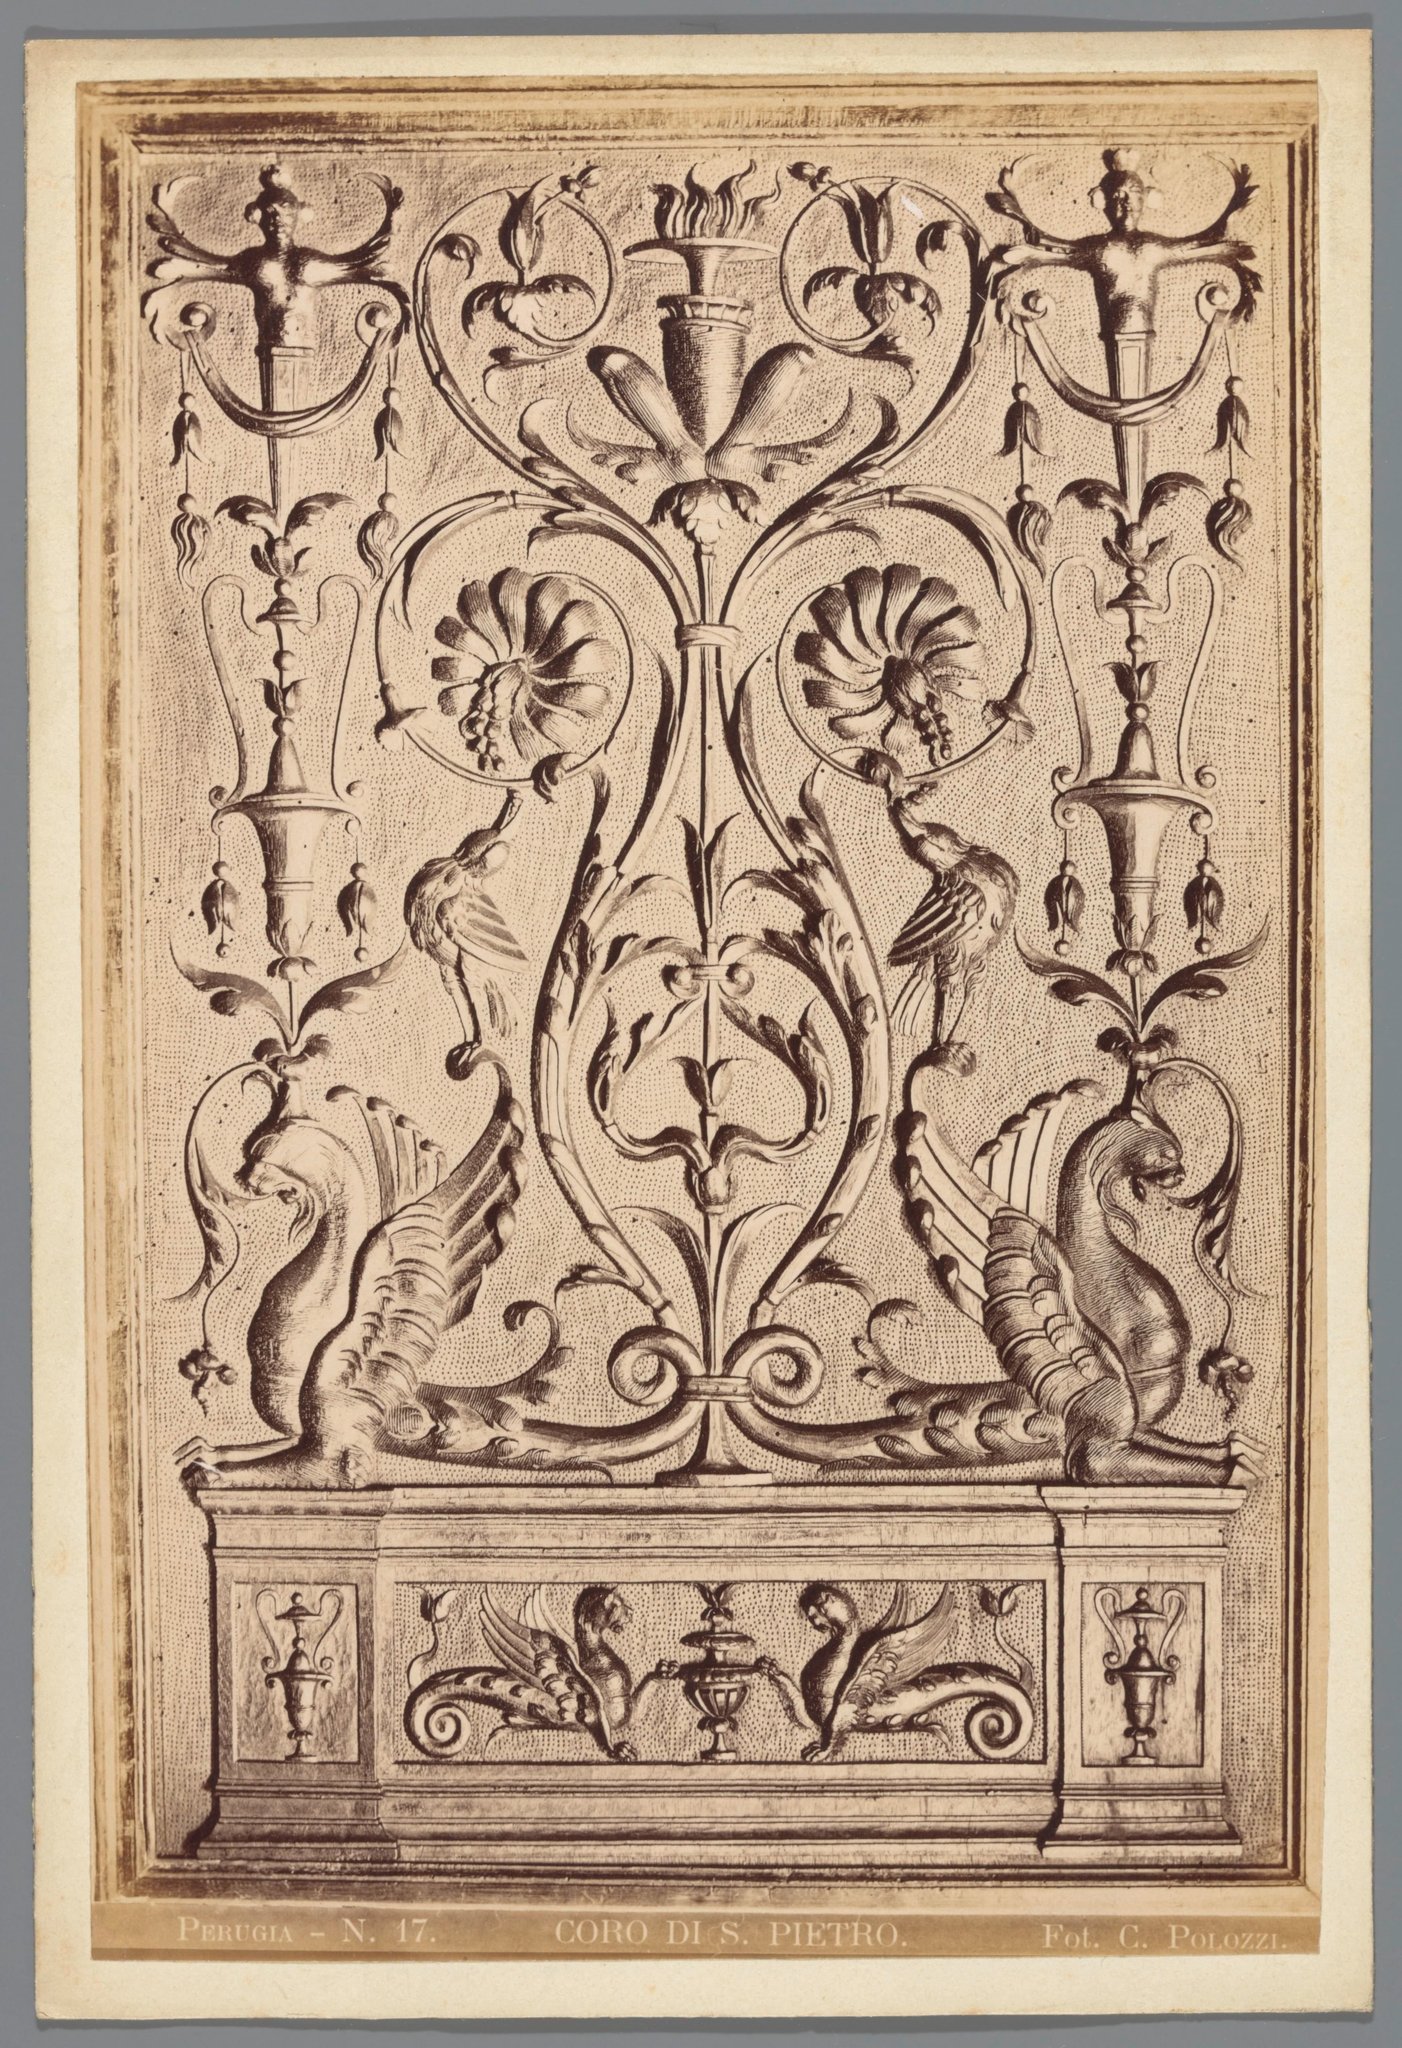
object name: photograph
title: Reliëf in de San Pietro te Perugia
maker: c. polozzi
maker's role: fotograaf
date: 1851-1900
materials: cardboard, paper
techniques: albumen print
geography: perugia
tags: door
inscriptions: number: ‘N. 17.’